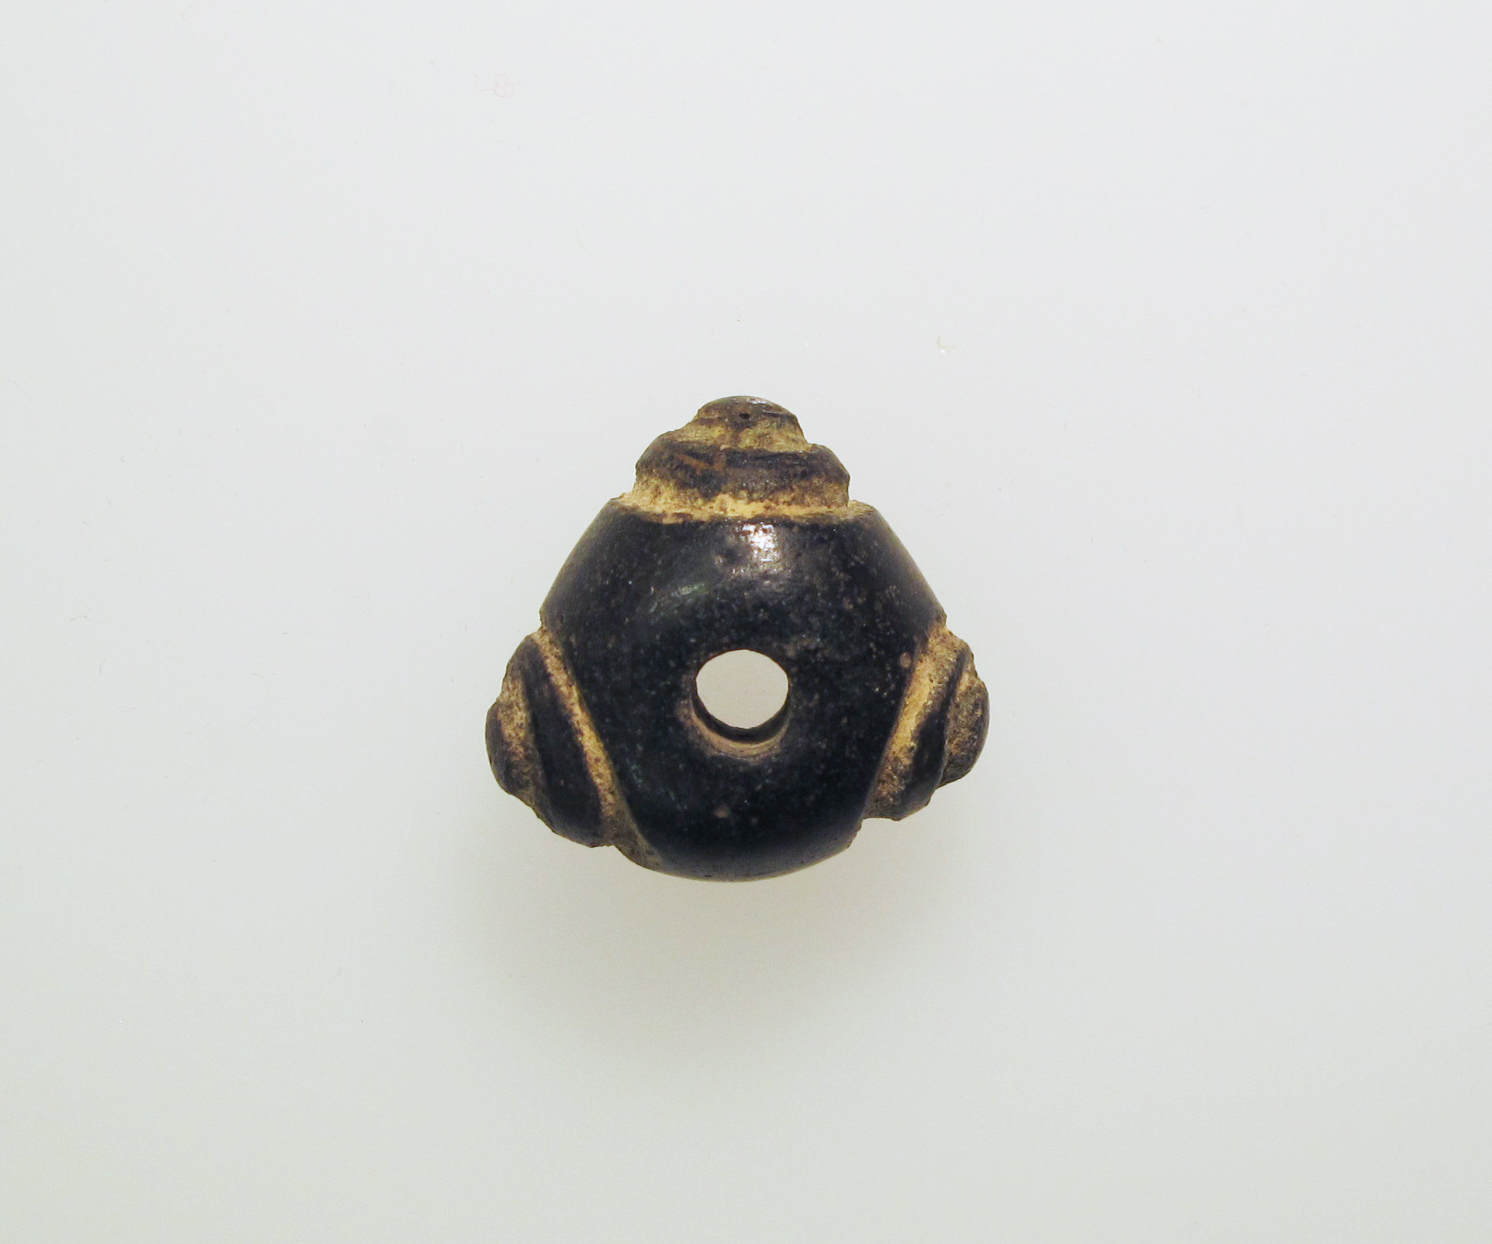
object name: bead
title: Glass eye bead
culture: phoenician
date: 700-701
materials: glass